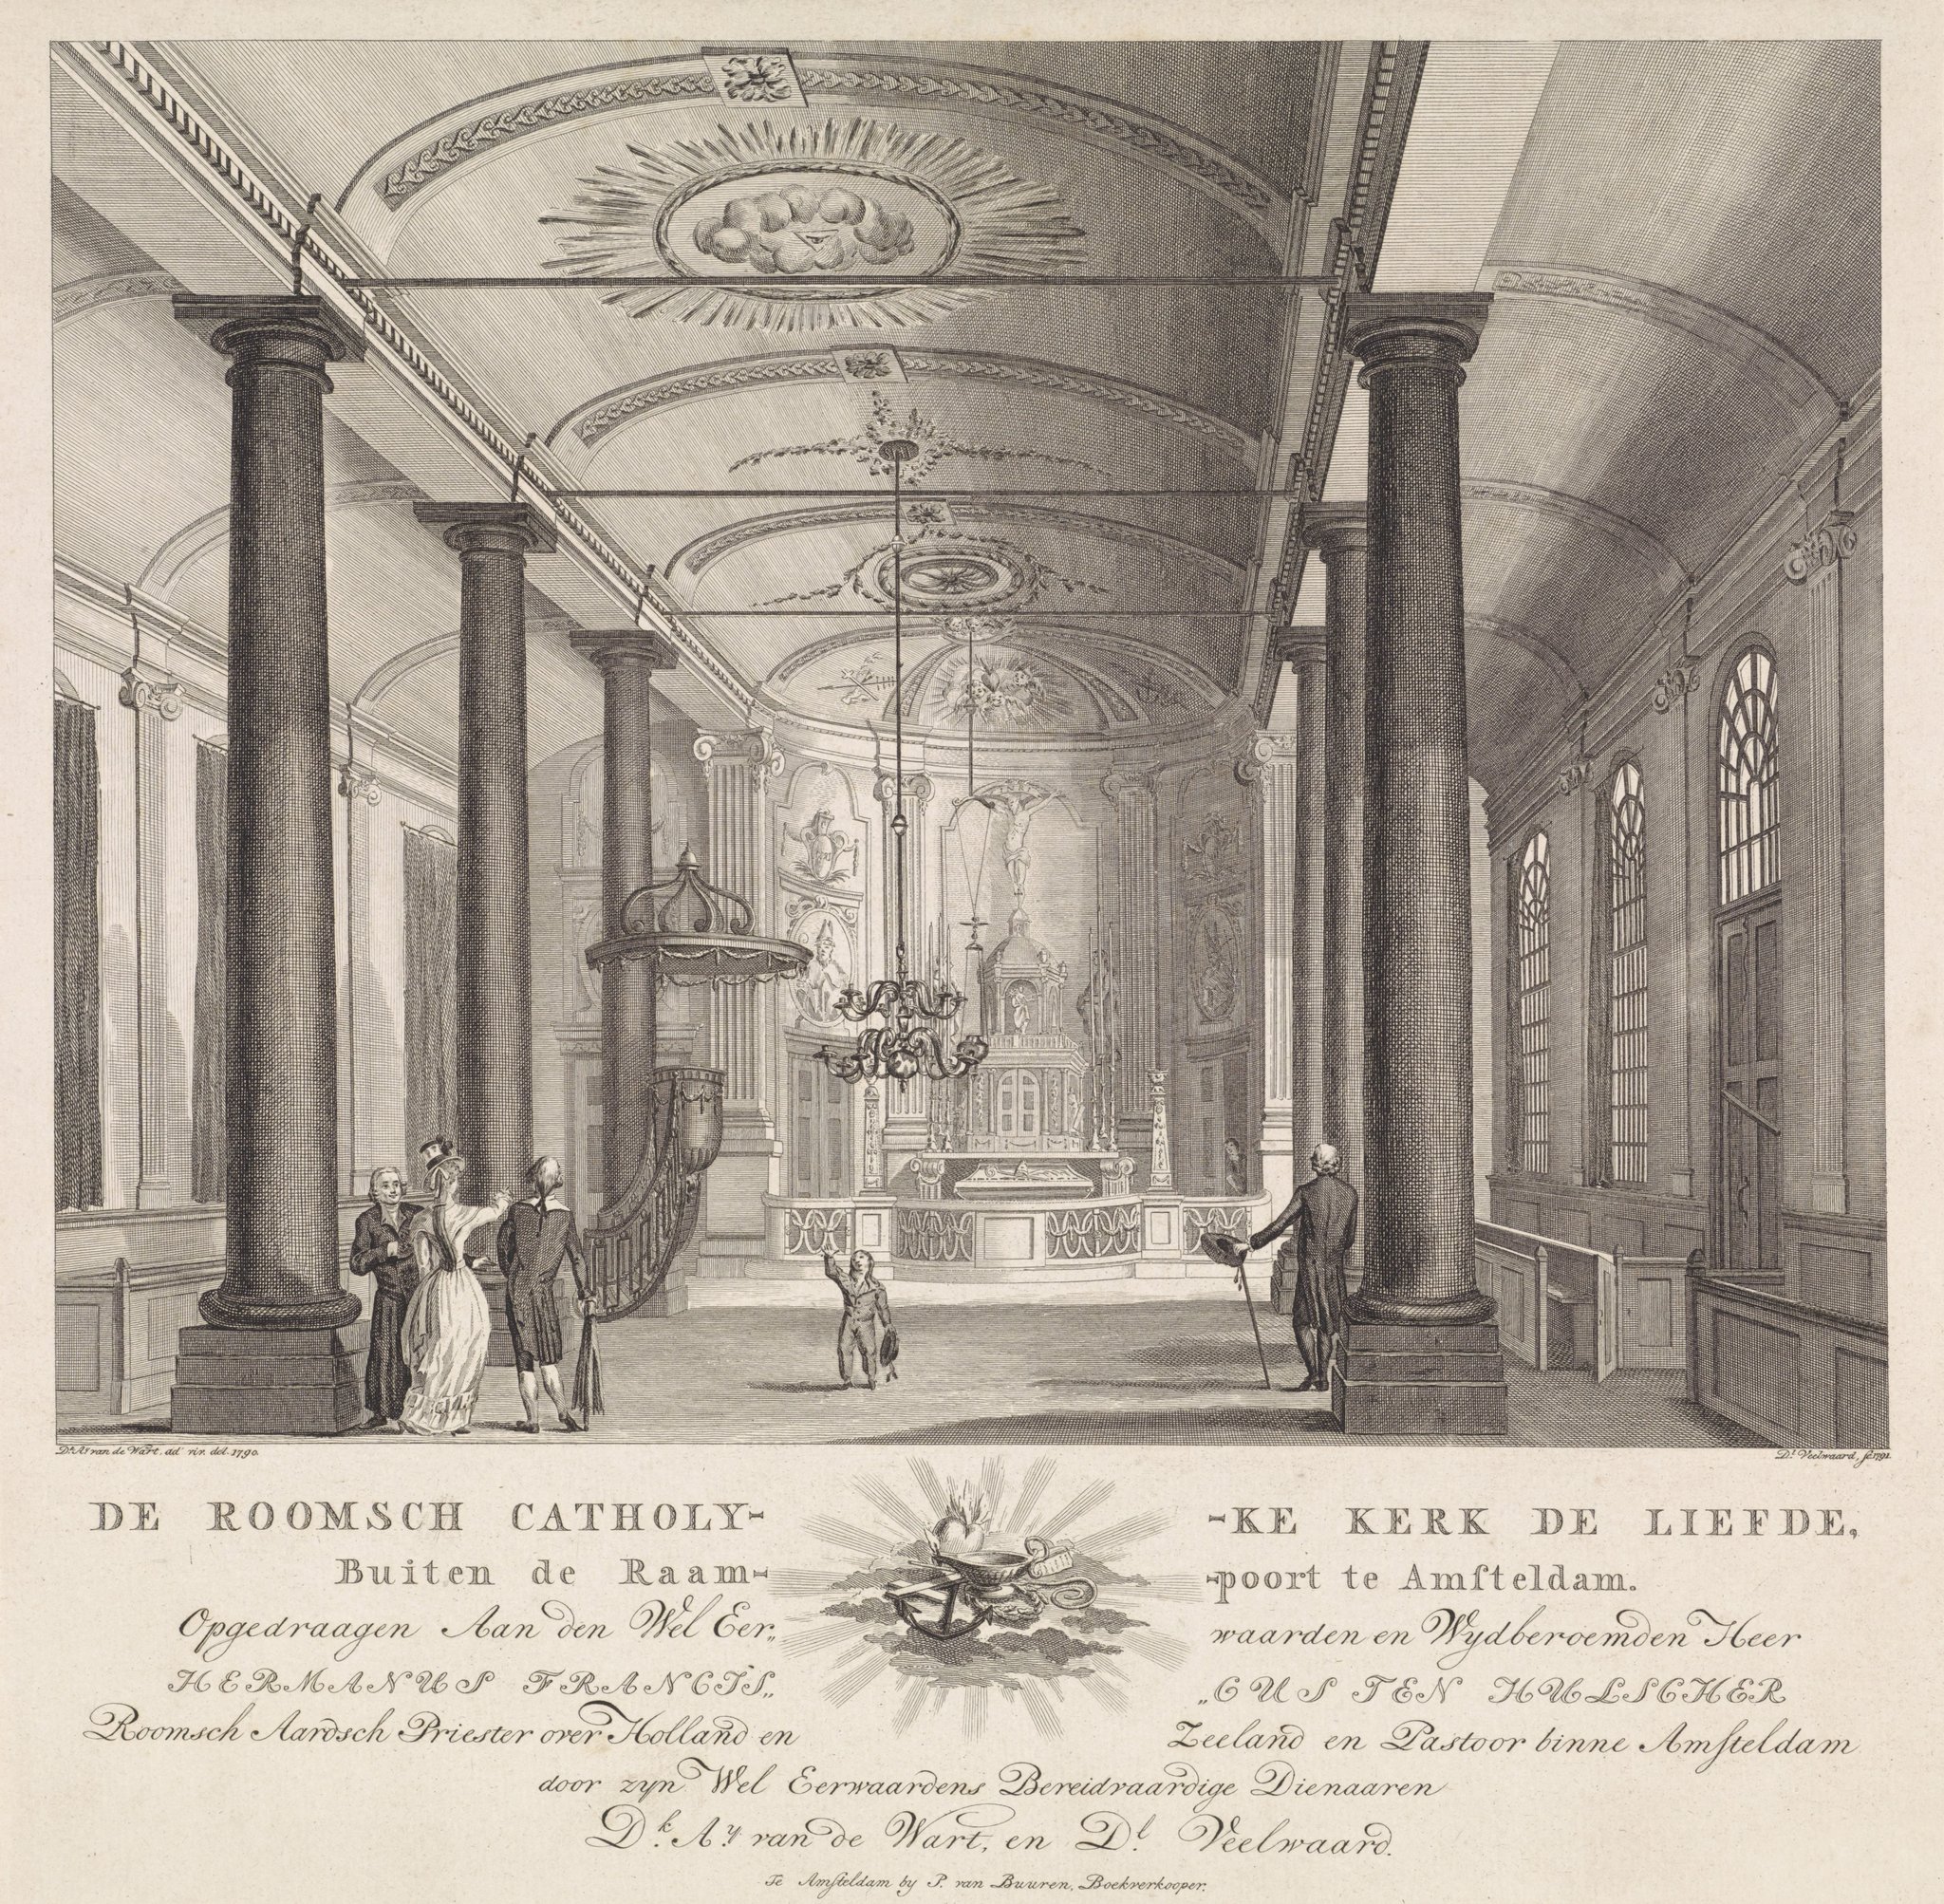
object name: print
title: De Roomsch Catholyke Kerk De Liefde, Buiten de Raampoort te Amsteldam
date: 1791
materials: paper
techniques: engraving, etching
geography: amsterdam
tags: interior of church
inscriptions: collector's mark: Lugt 2228